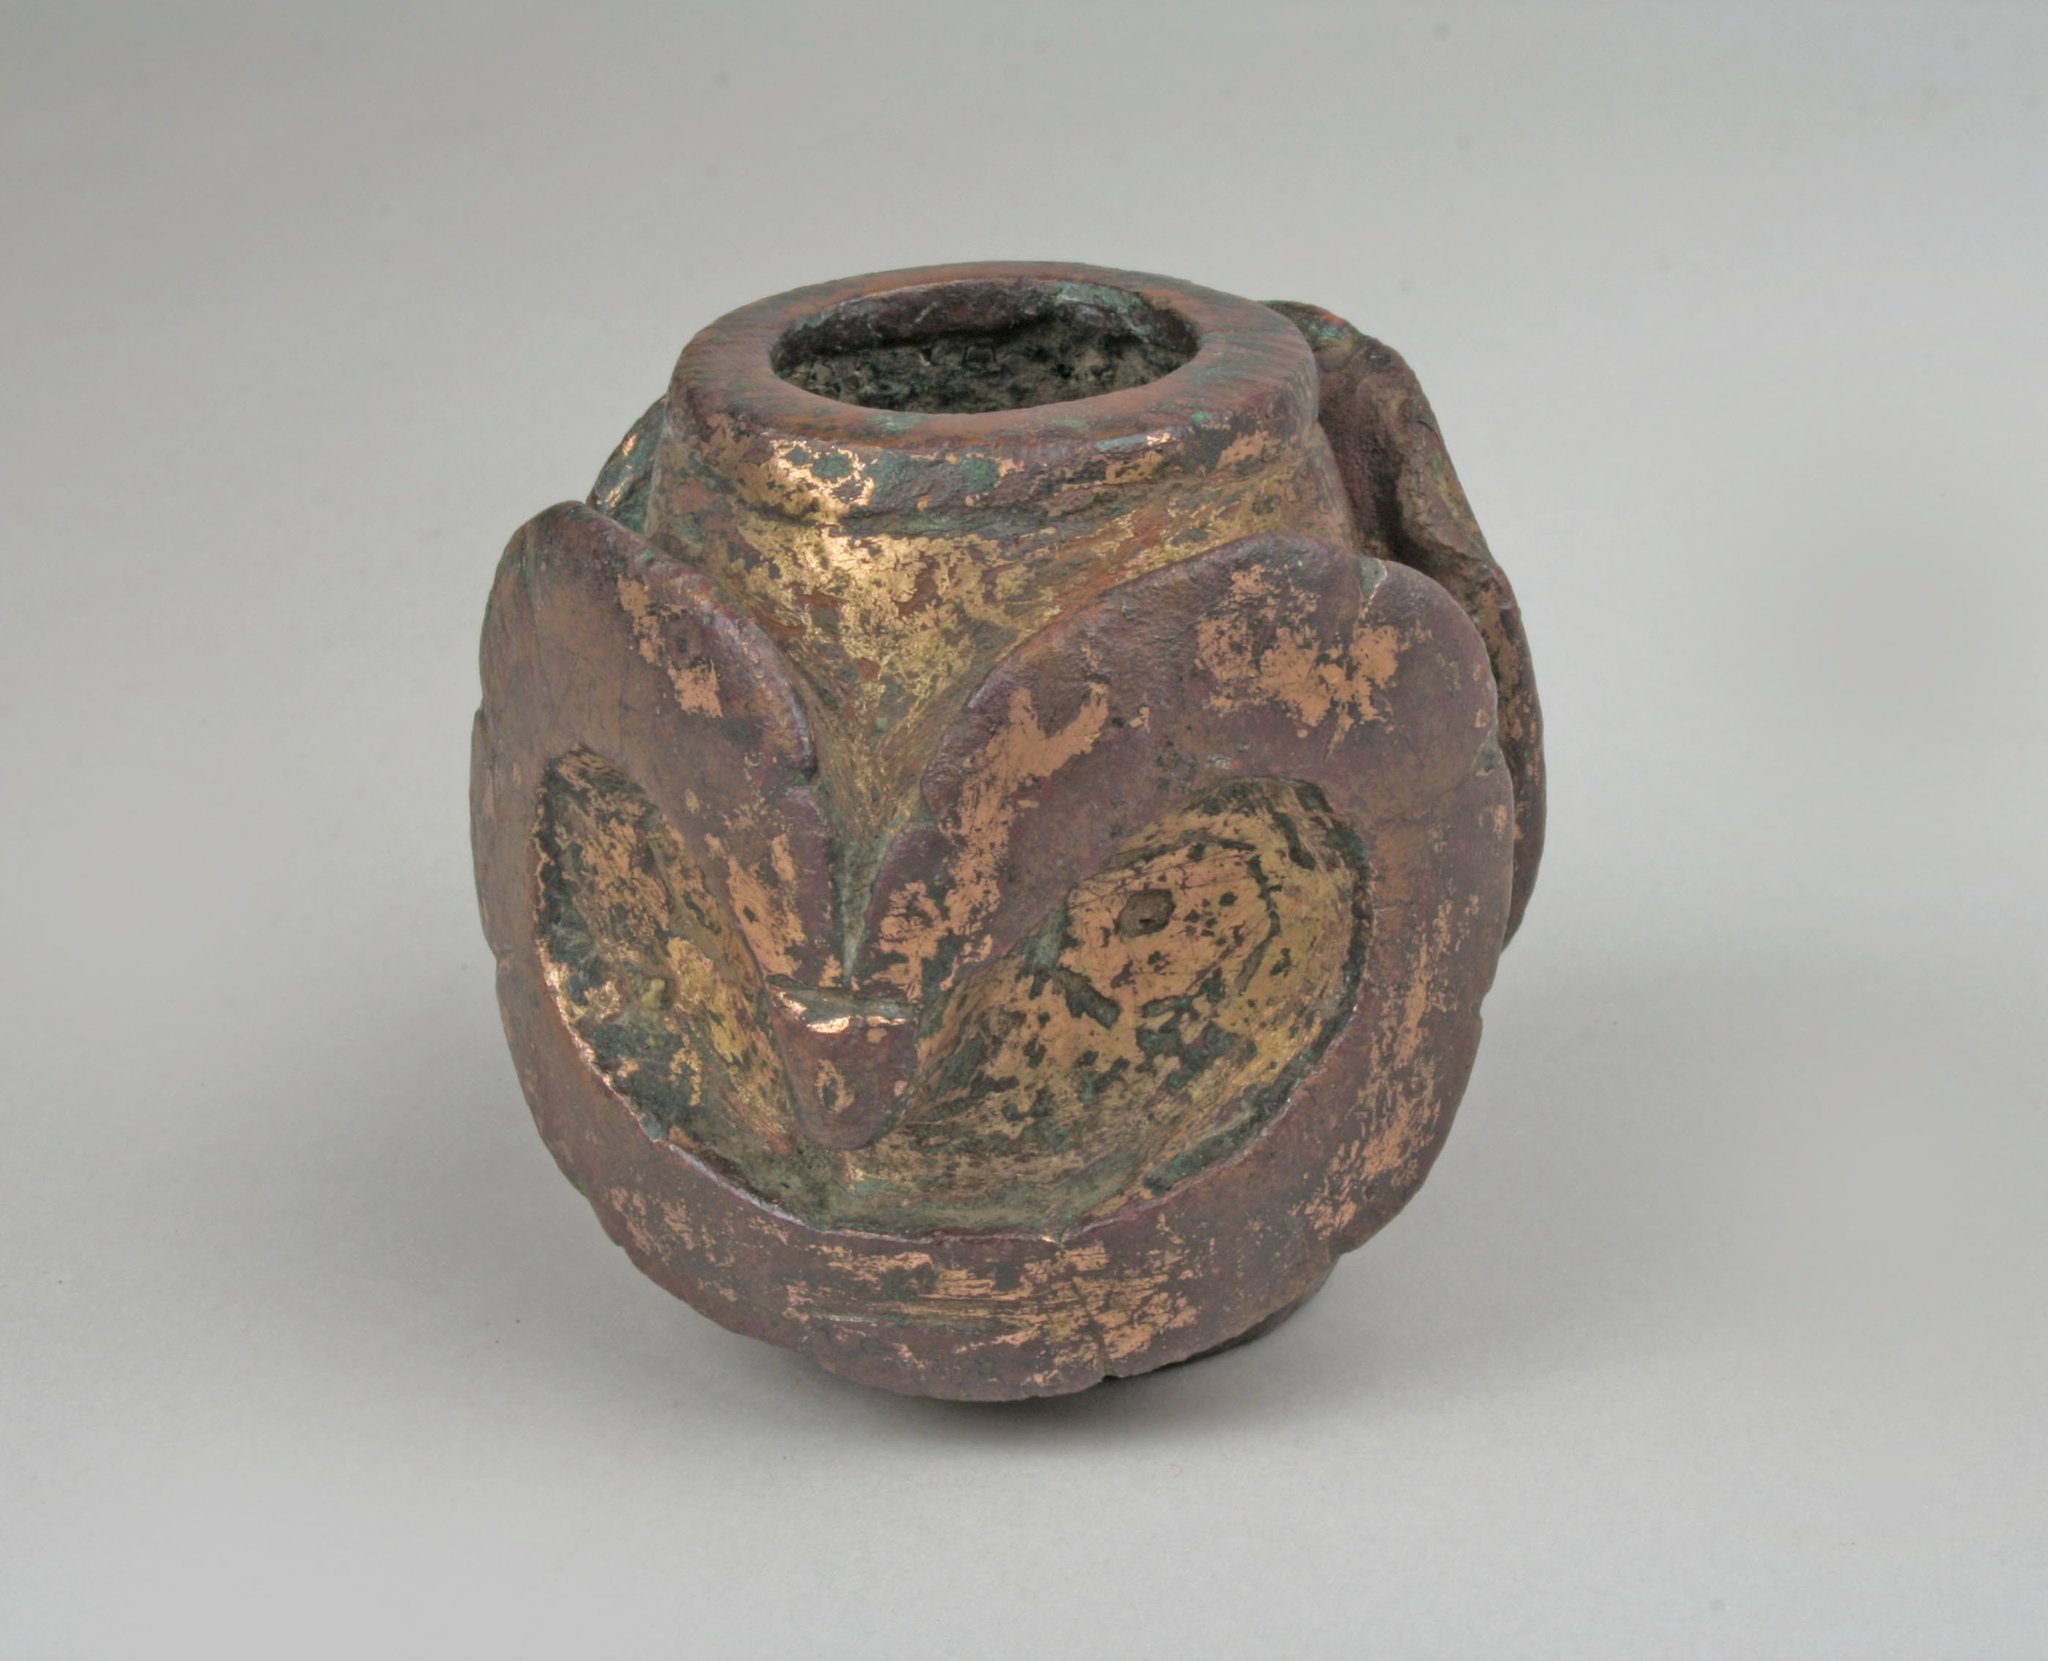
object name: mace head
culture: moche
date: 1-700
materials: copper, gilt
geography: peru